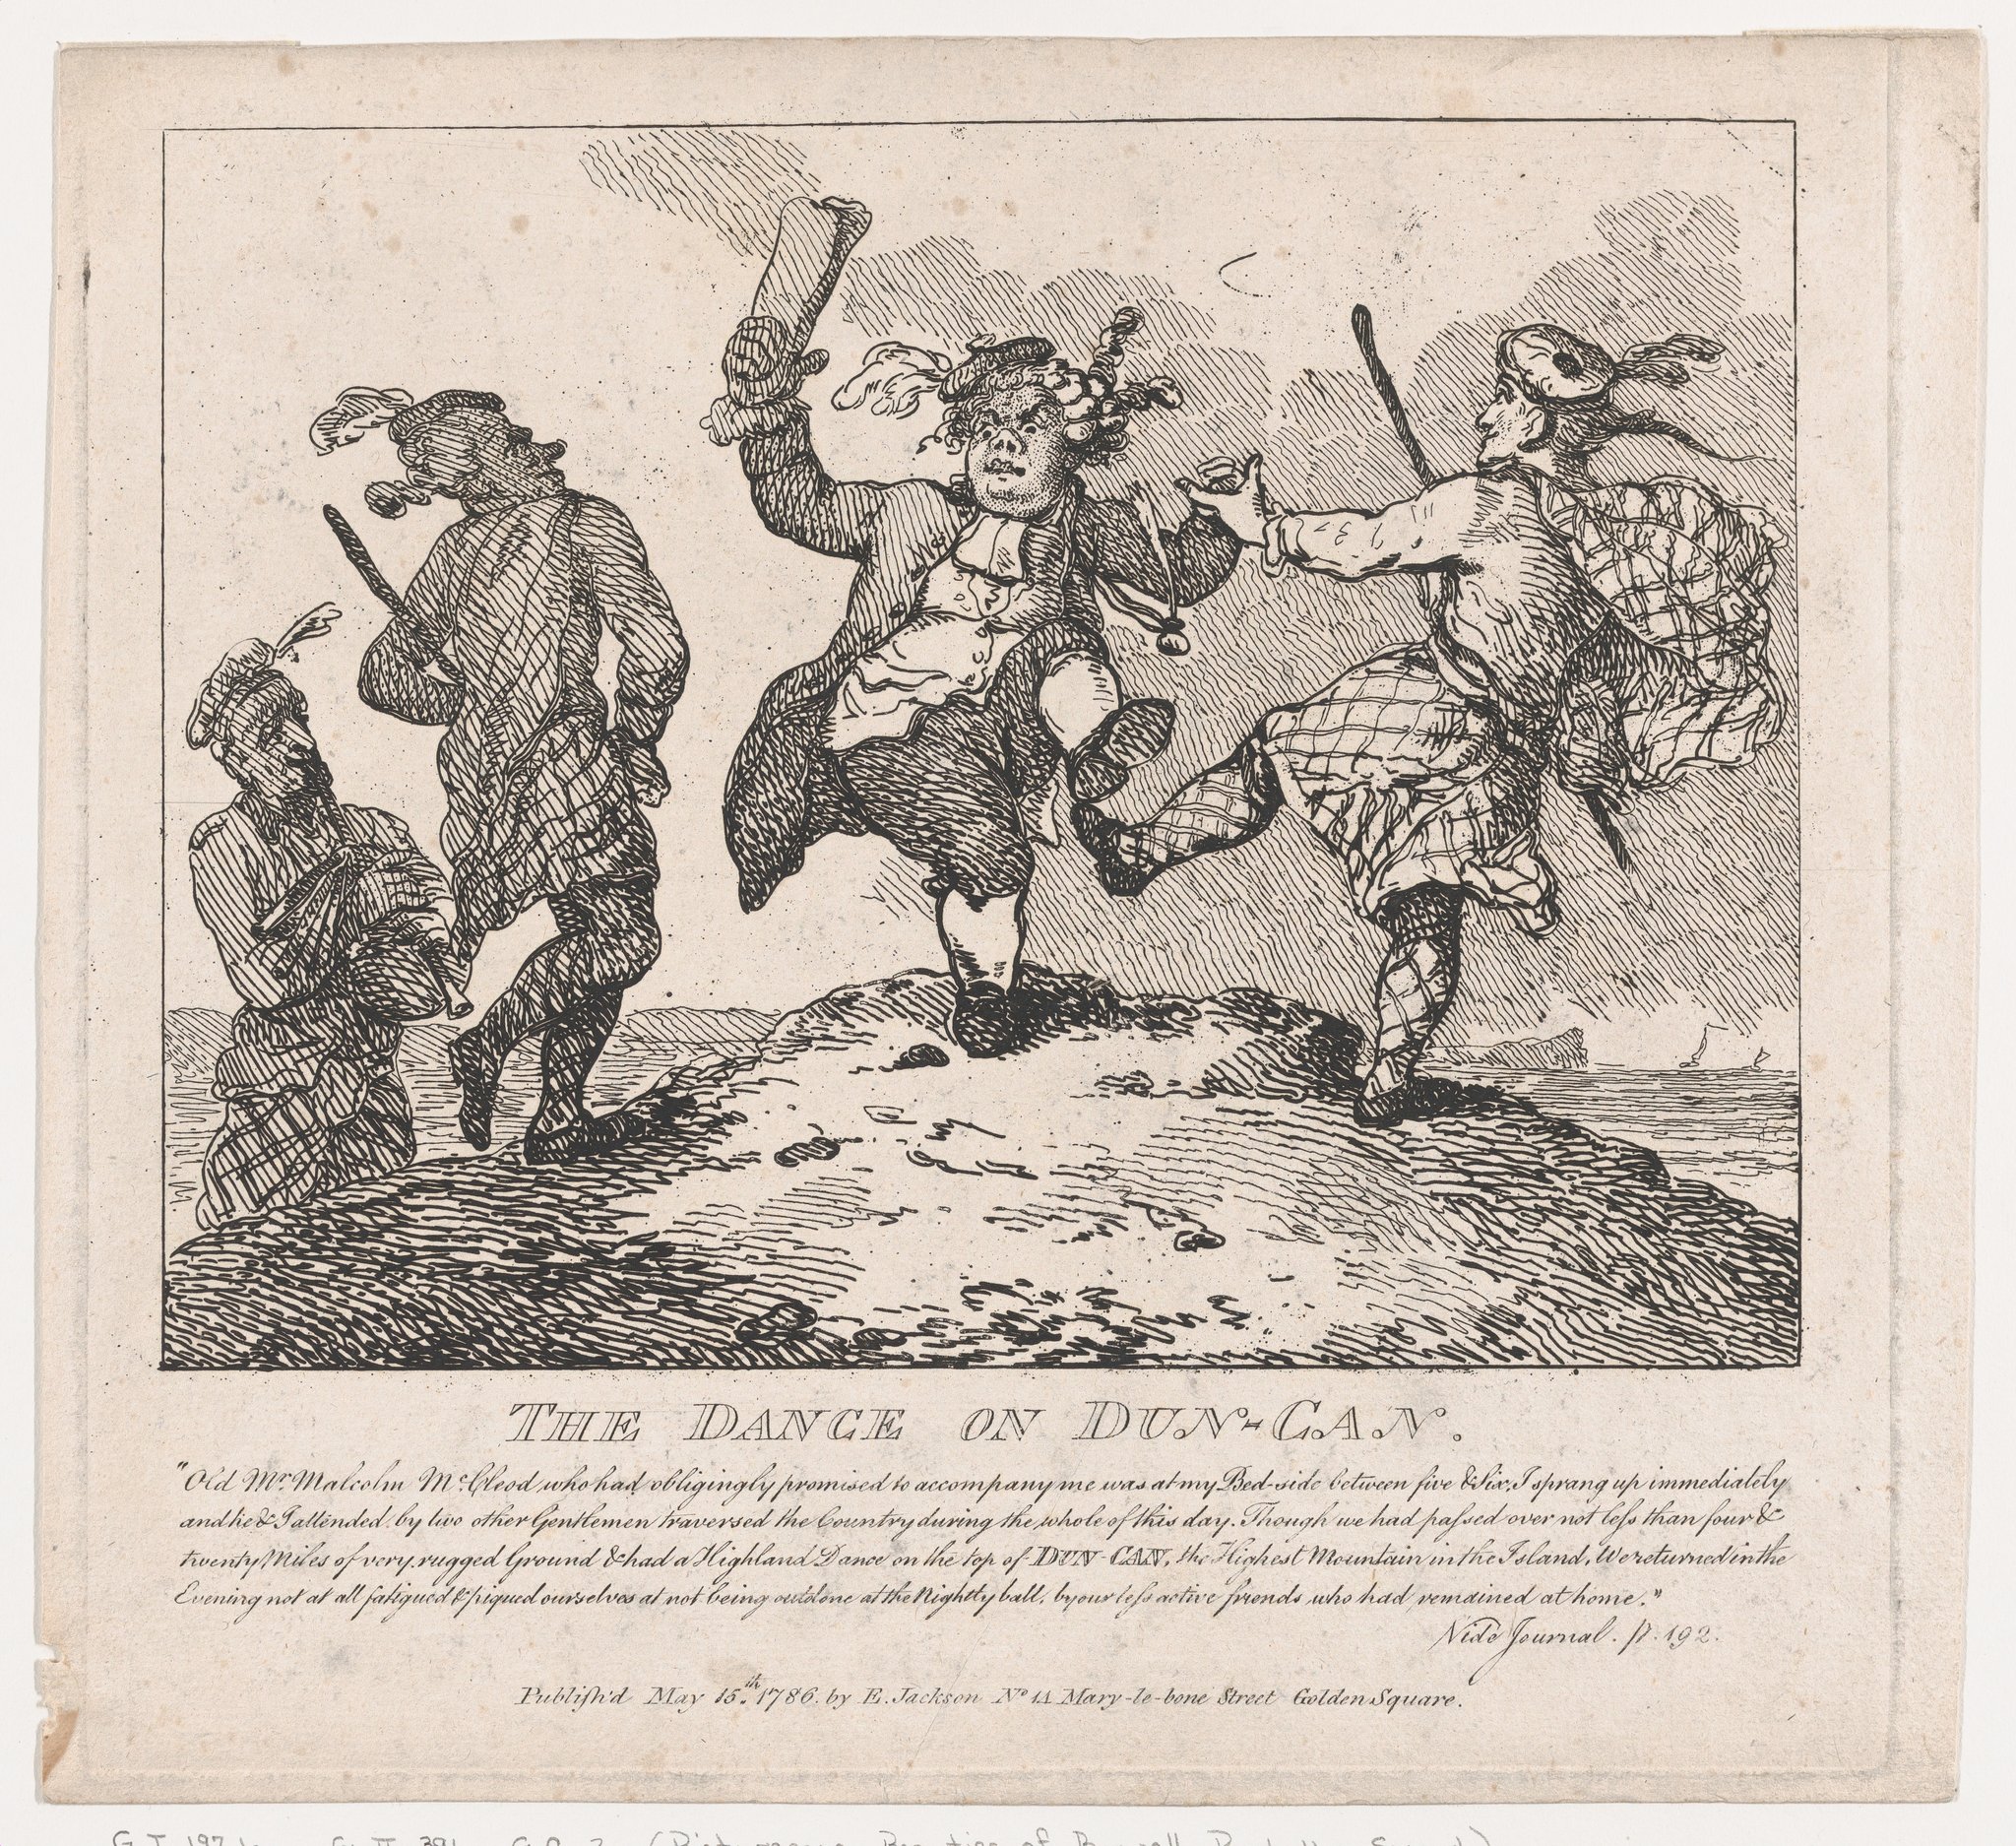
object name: print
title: The Dance on Dun-Can (Picturesque Beauties of Boswell, Part the Second)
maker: thomas rowlandson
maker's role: artist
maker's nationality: british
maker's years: 1757-1827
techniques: etching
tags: dance,men